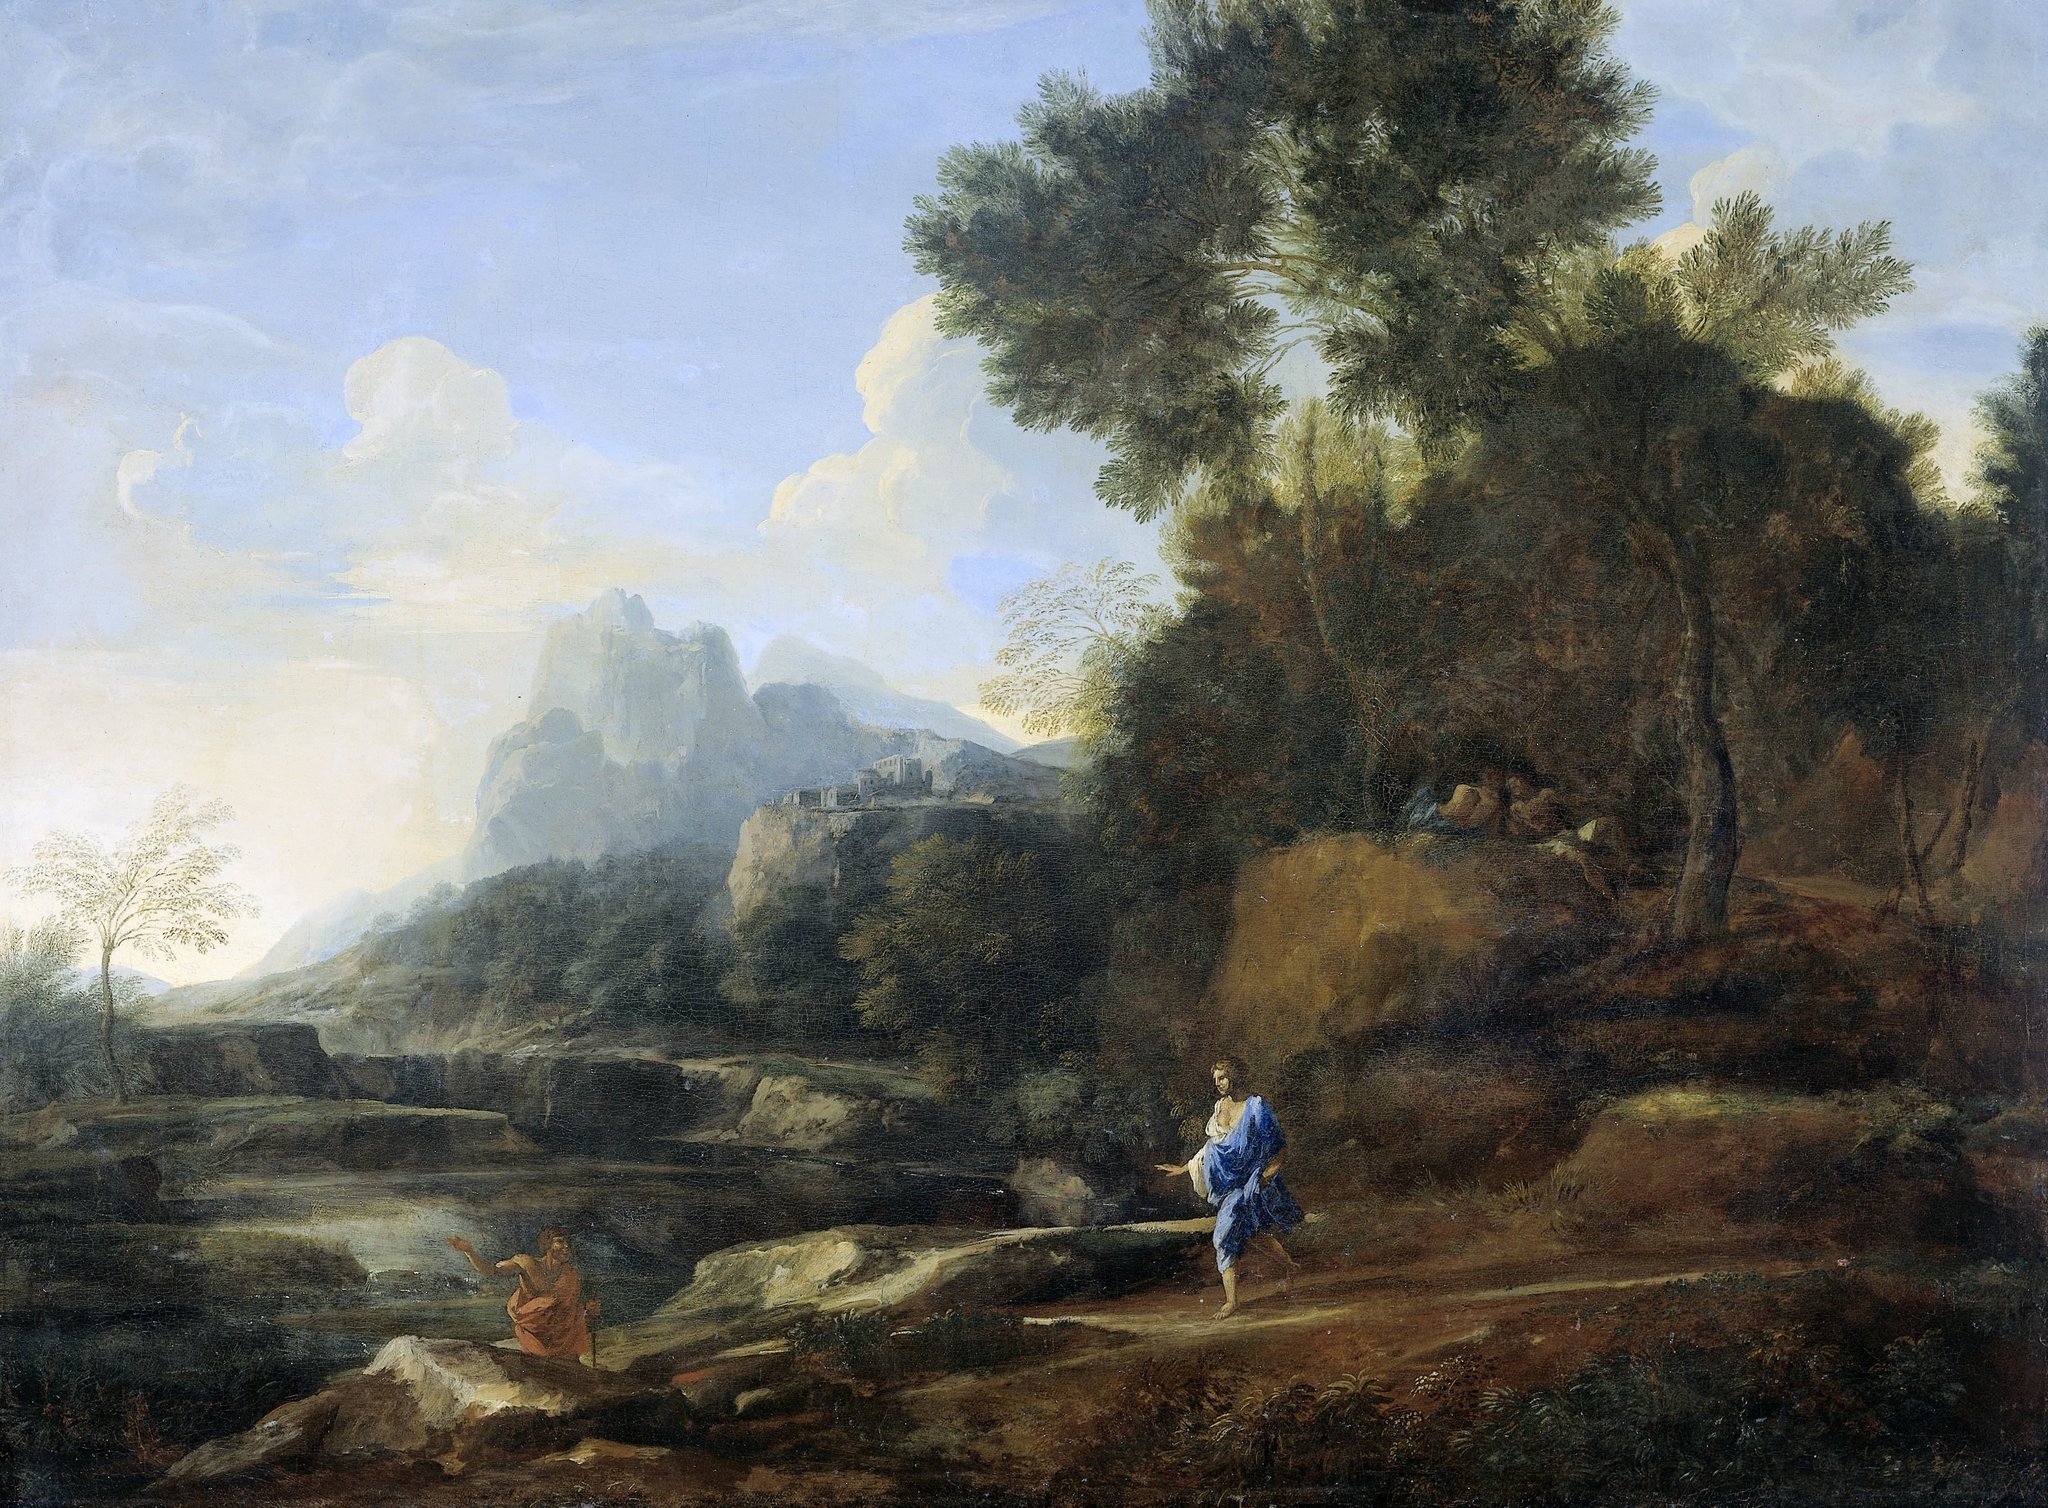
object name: painting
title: Italian Landscape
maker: gaspard dughet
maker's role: draughtsman, painter, print maker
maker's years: 1615-1675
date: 1638-1640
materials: canvas, oil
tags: river, (high) hill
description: Italiaans landschap. Twee figuren ontmoeten elkaar bij de oever van een rivier.